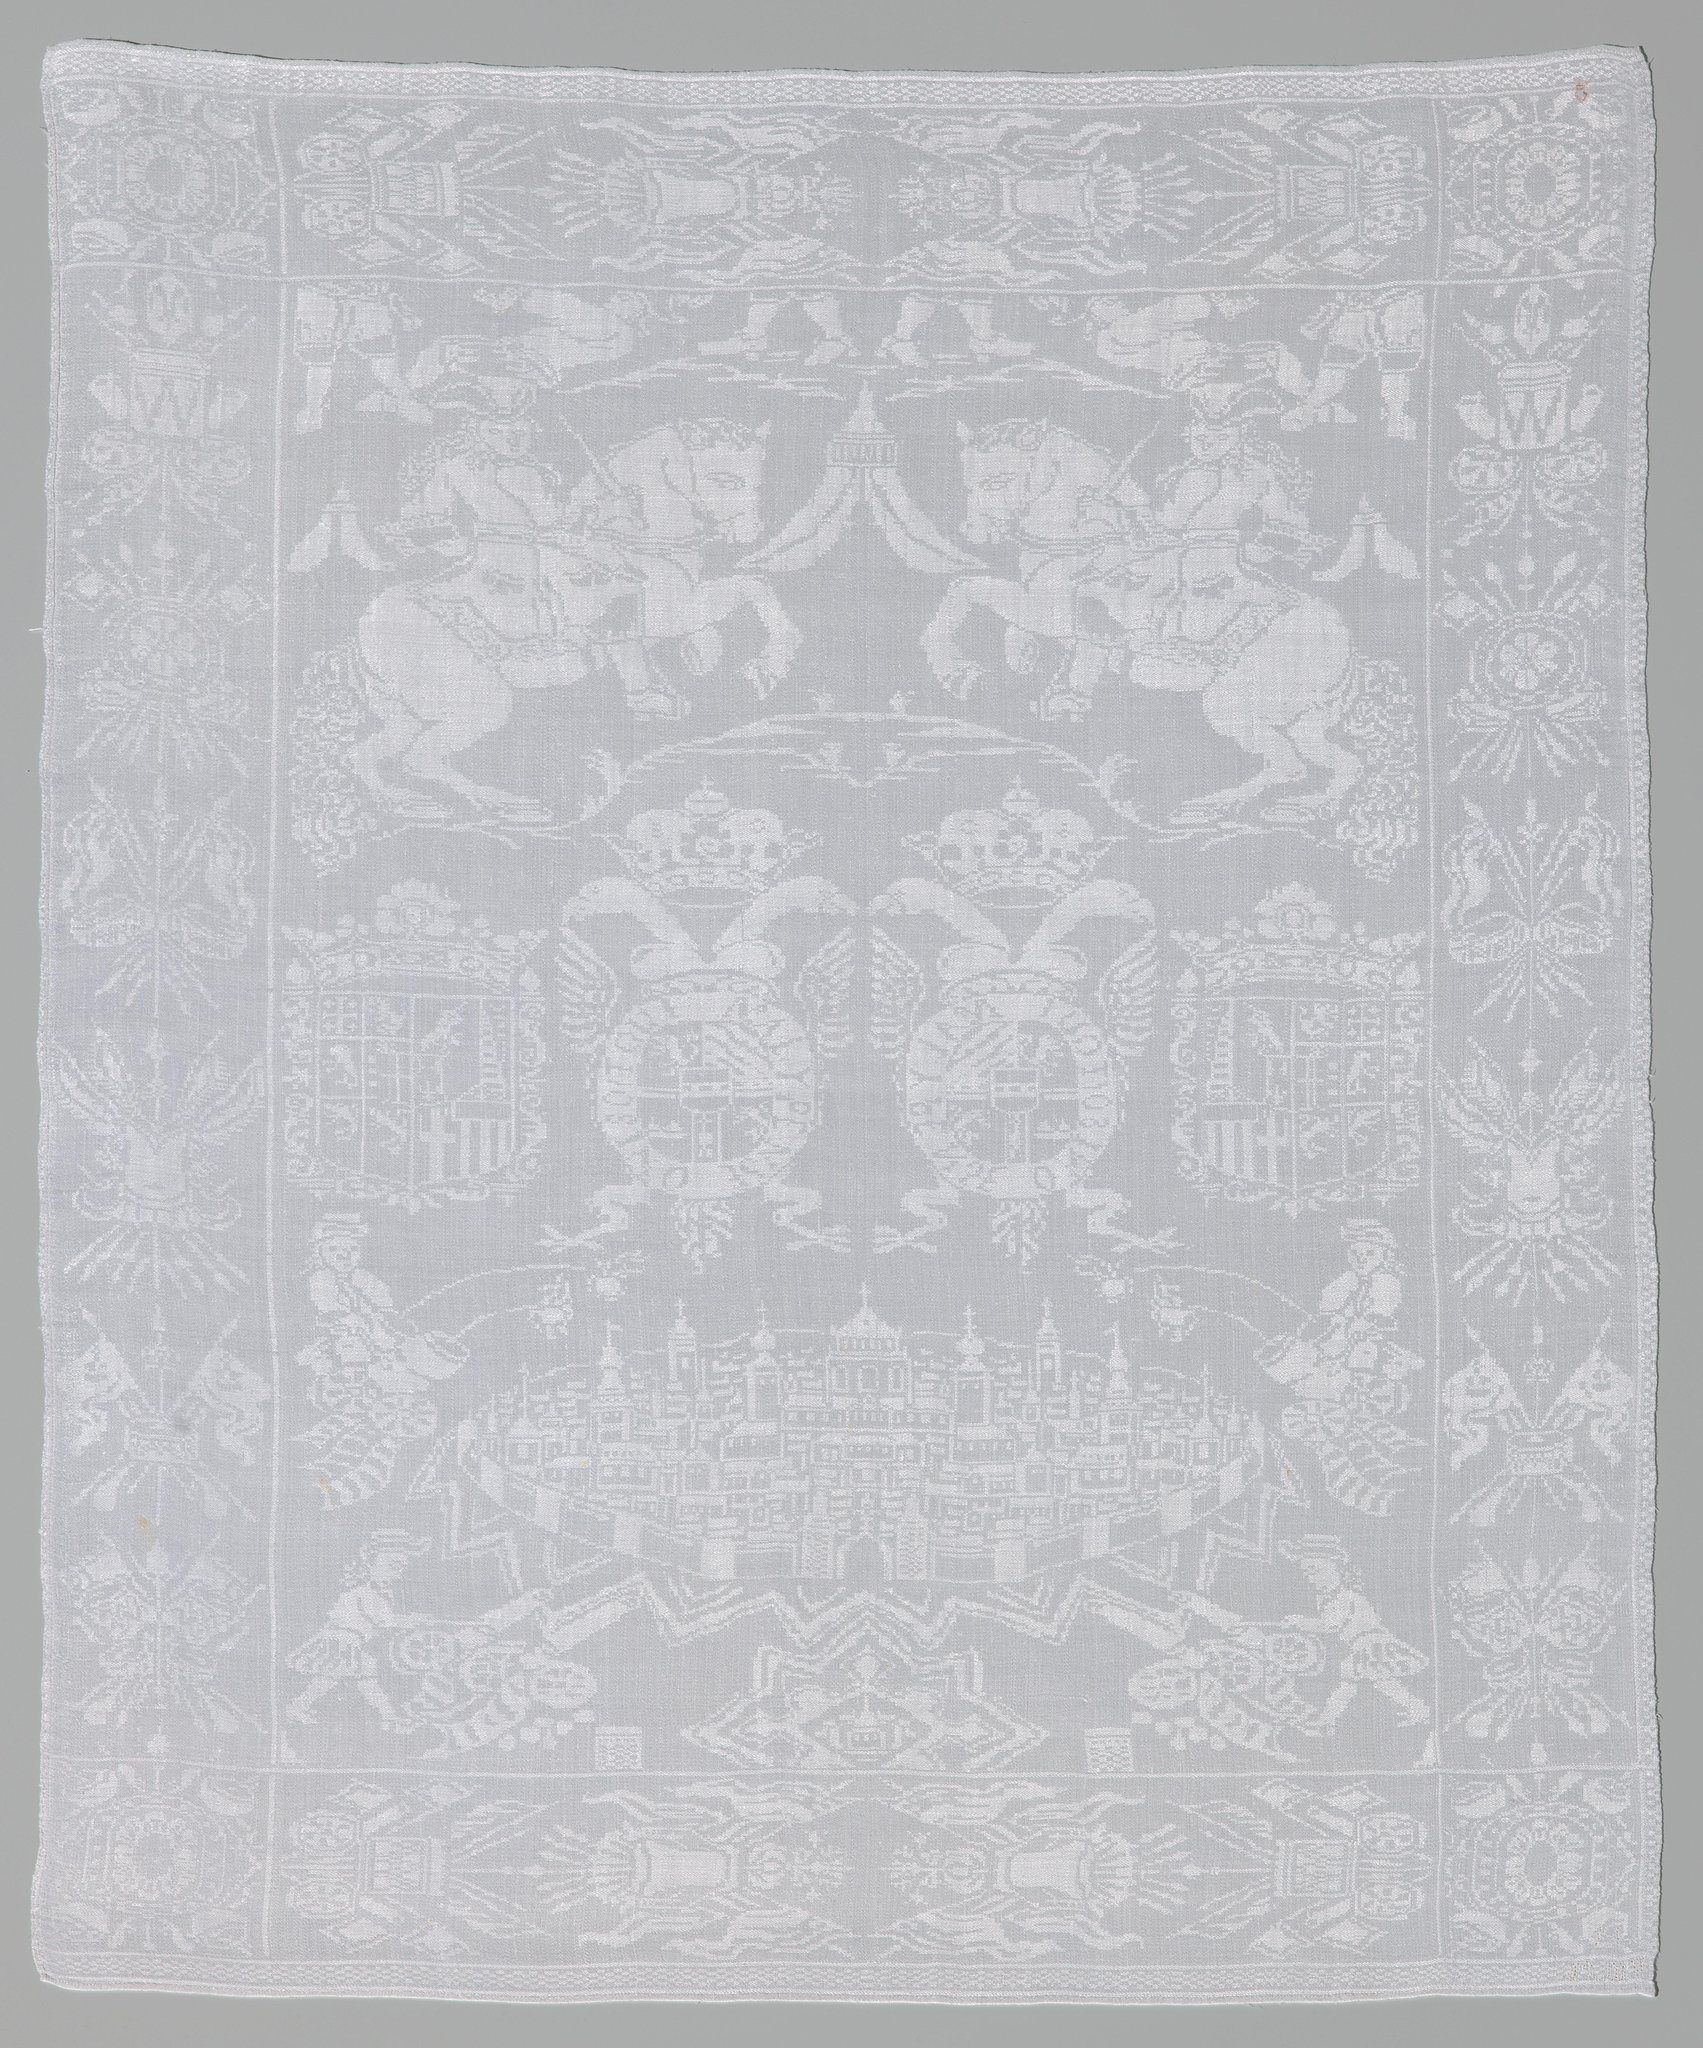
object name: napkin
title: Servet van wit linnendamast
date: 1708-1710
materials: linen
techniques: damask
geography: flanders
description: Wit linnen damasten servet met wapenfeiten uit de Spaanse Successie-oorlog. Gemerkt A M V P 16 en gekroonde V.